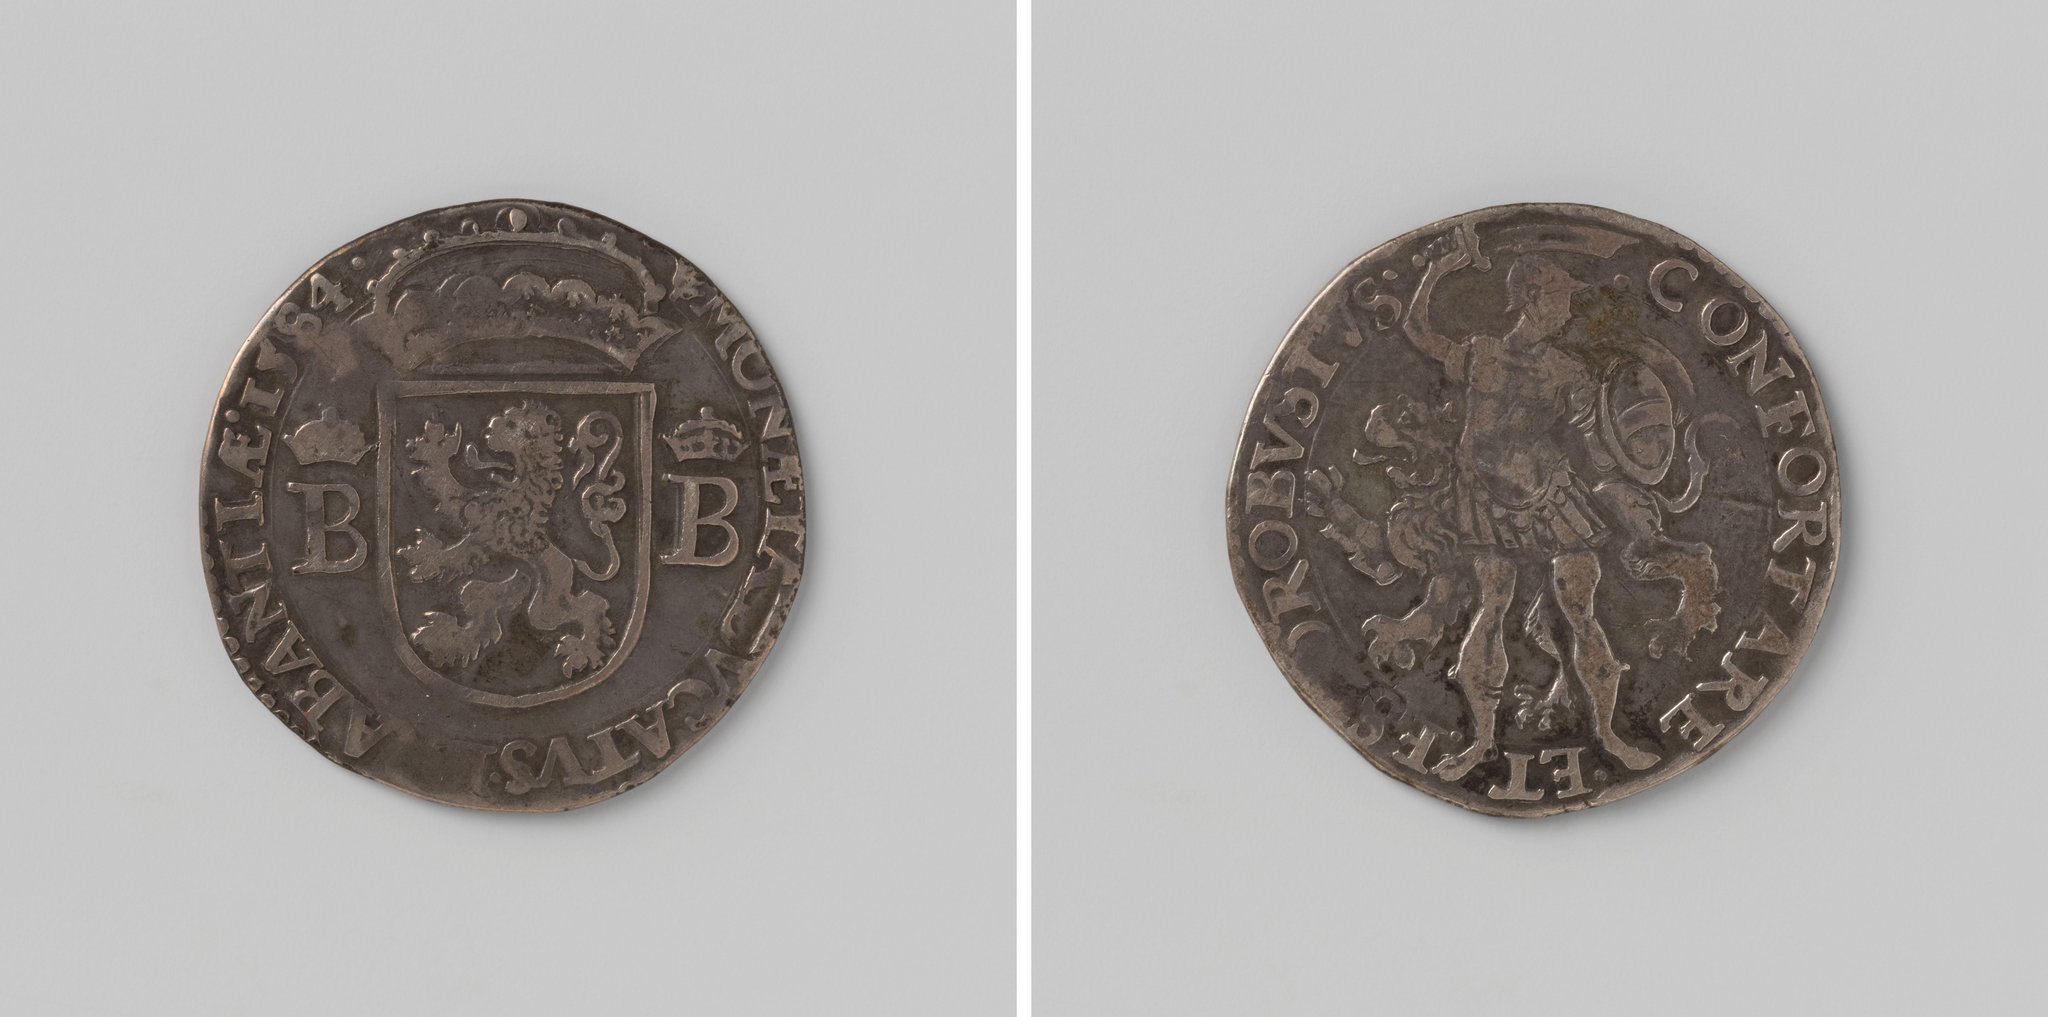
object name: medal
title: Vrije hertogdom Brabant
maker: Anonymous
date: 1584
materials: silver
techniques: striking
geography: brabant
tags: brabant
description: Zilveren penning. Voorzijde: soldaat met getrokken zwaard en schild binnen omschrift. Keerzijde: gekroond wapenschild tussen twee gekroonde B's binnen omschrift